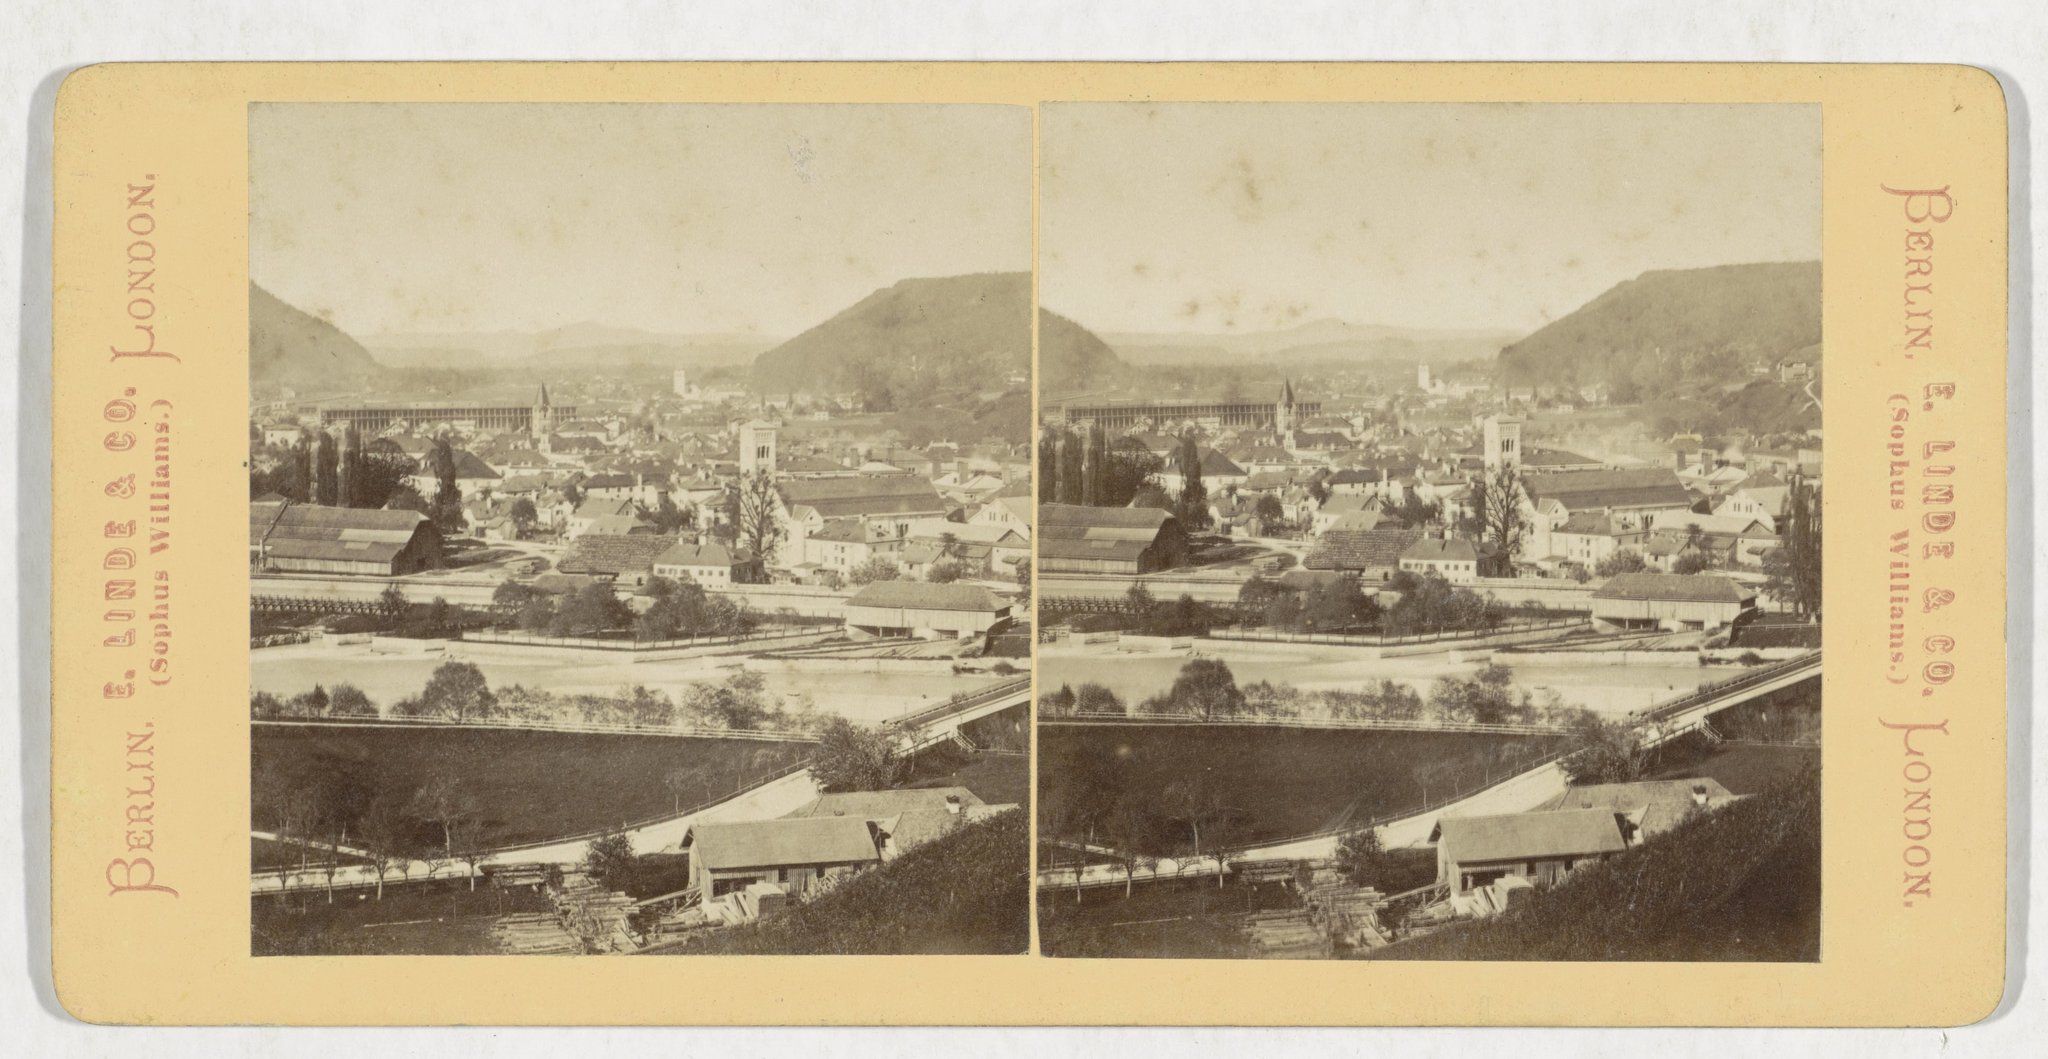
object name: stereograph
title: Gezicht op de westkant van Bad Reichenhall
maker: Anonymous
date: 1868-1890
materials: cardboard, paper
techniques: albumen print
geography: bad reichenhall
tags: city-view in general; 'veduta'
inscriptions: number: ‘No 10b.’